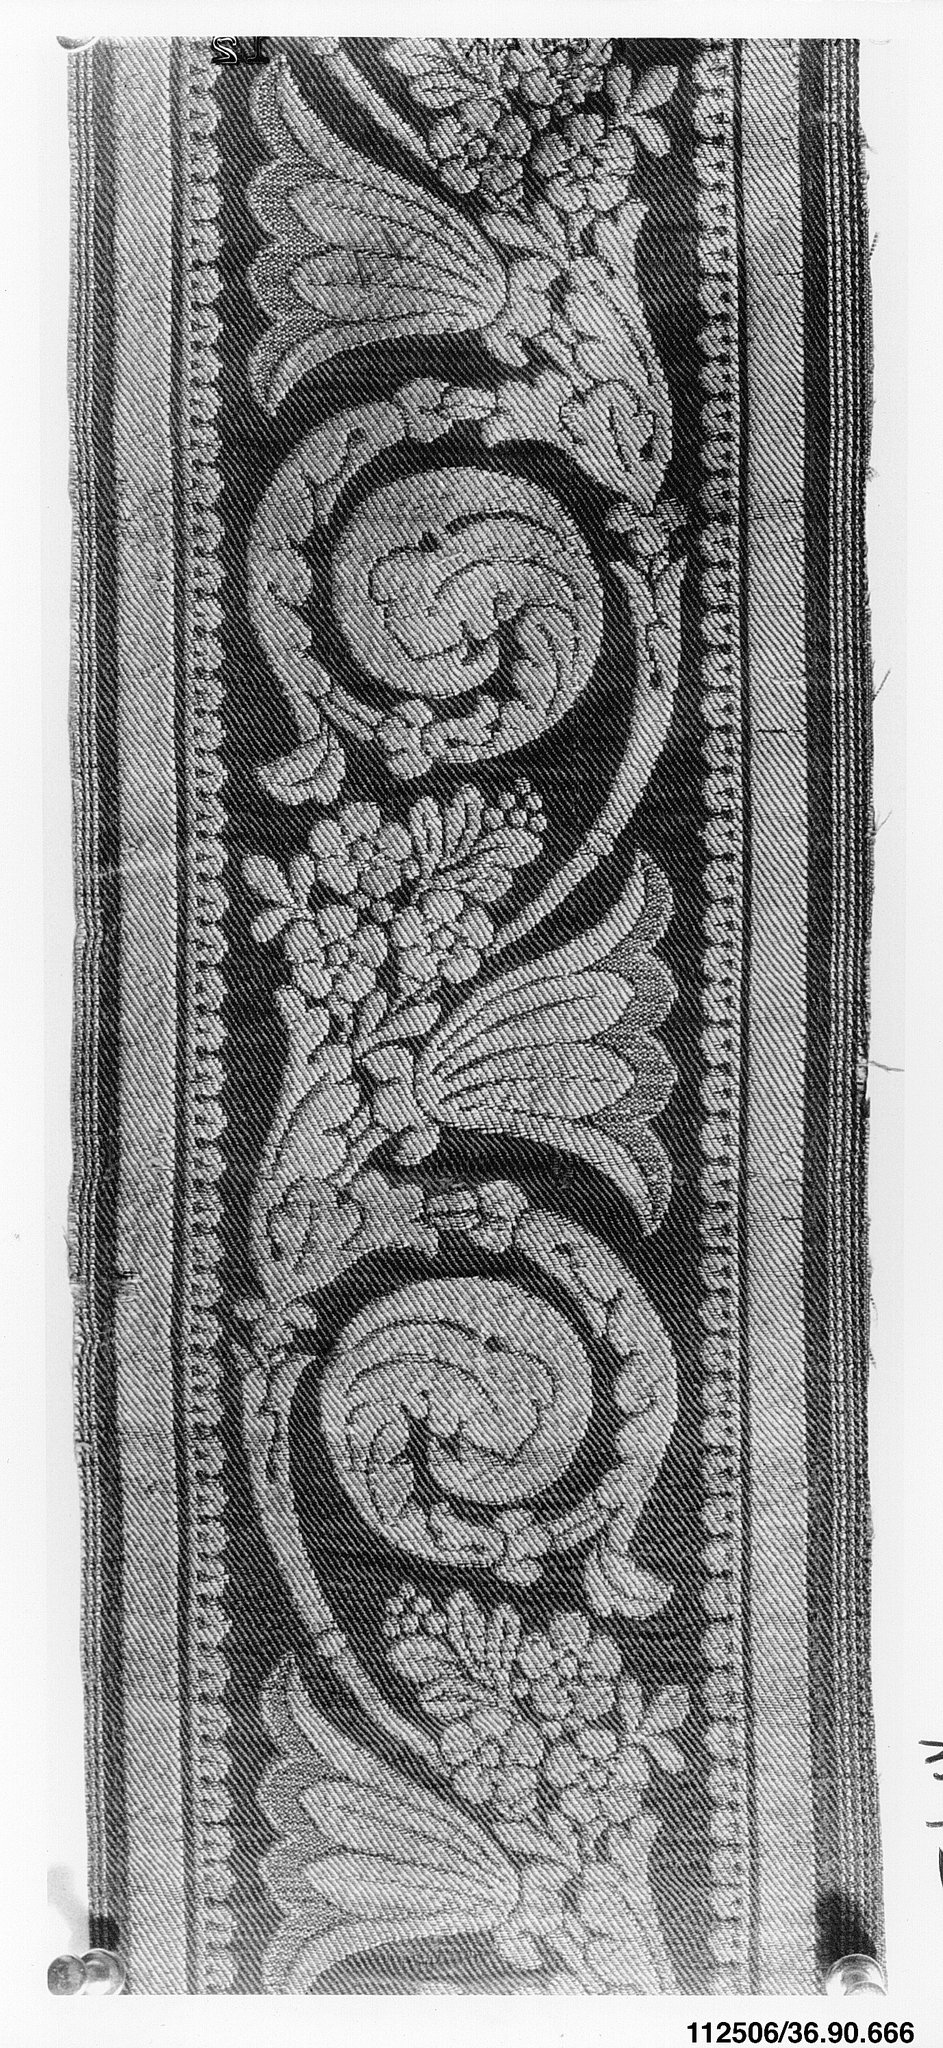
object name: piece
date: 1801-1833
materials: silk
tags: flowers